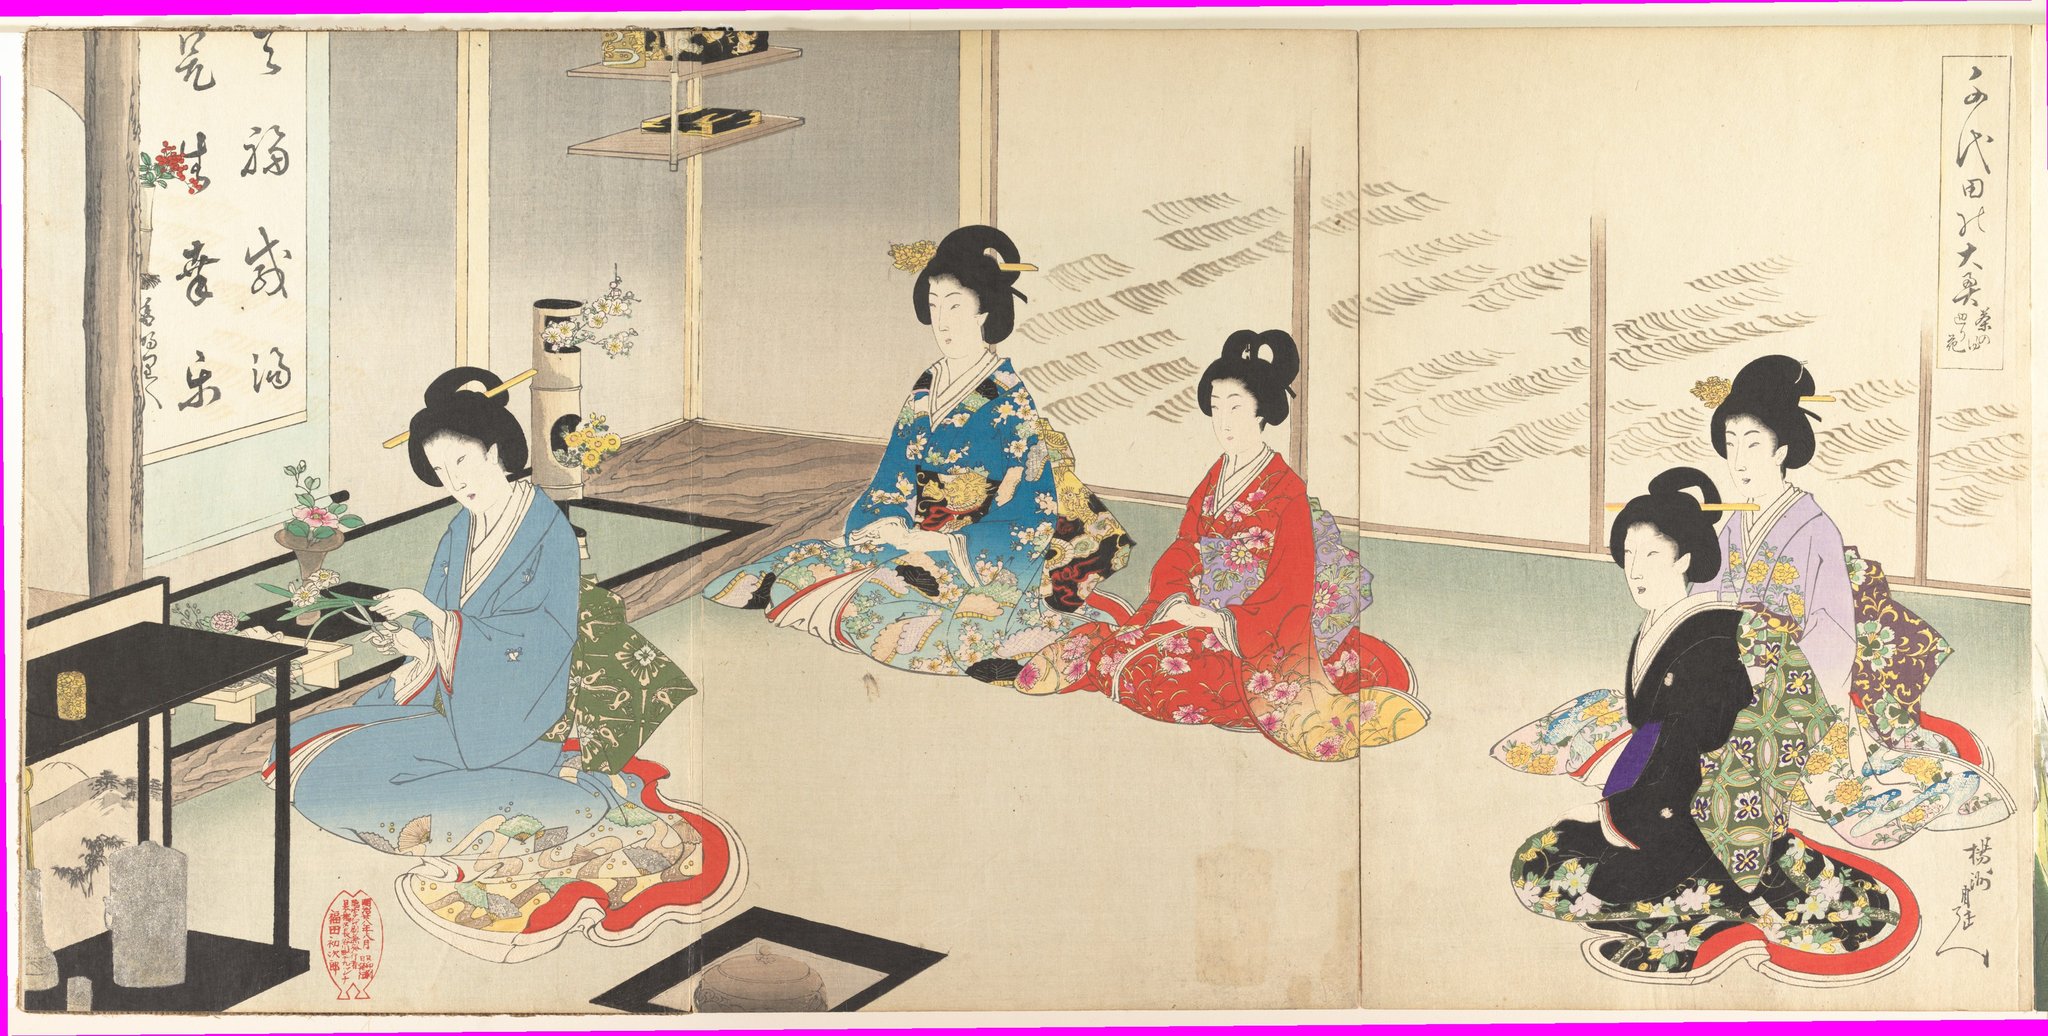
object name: print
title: Chiyoda Inner Palace: No.20 Flower Arranging in Turn (Chiyoda no Ōoku: Chanoyu mawaribana)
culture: japanese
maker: hashimoto chikanobu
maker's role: artist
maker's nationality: japanese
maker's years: 1838-1912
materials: ink, paper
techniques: woodblock print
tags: women